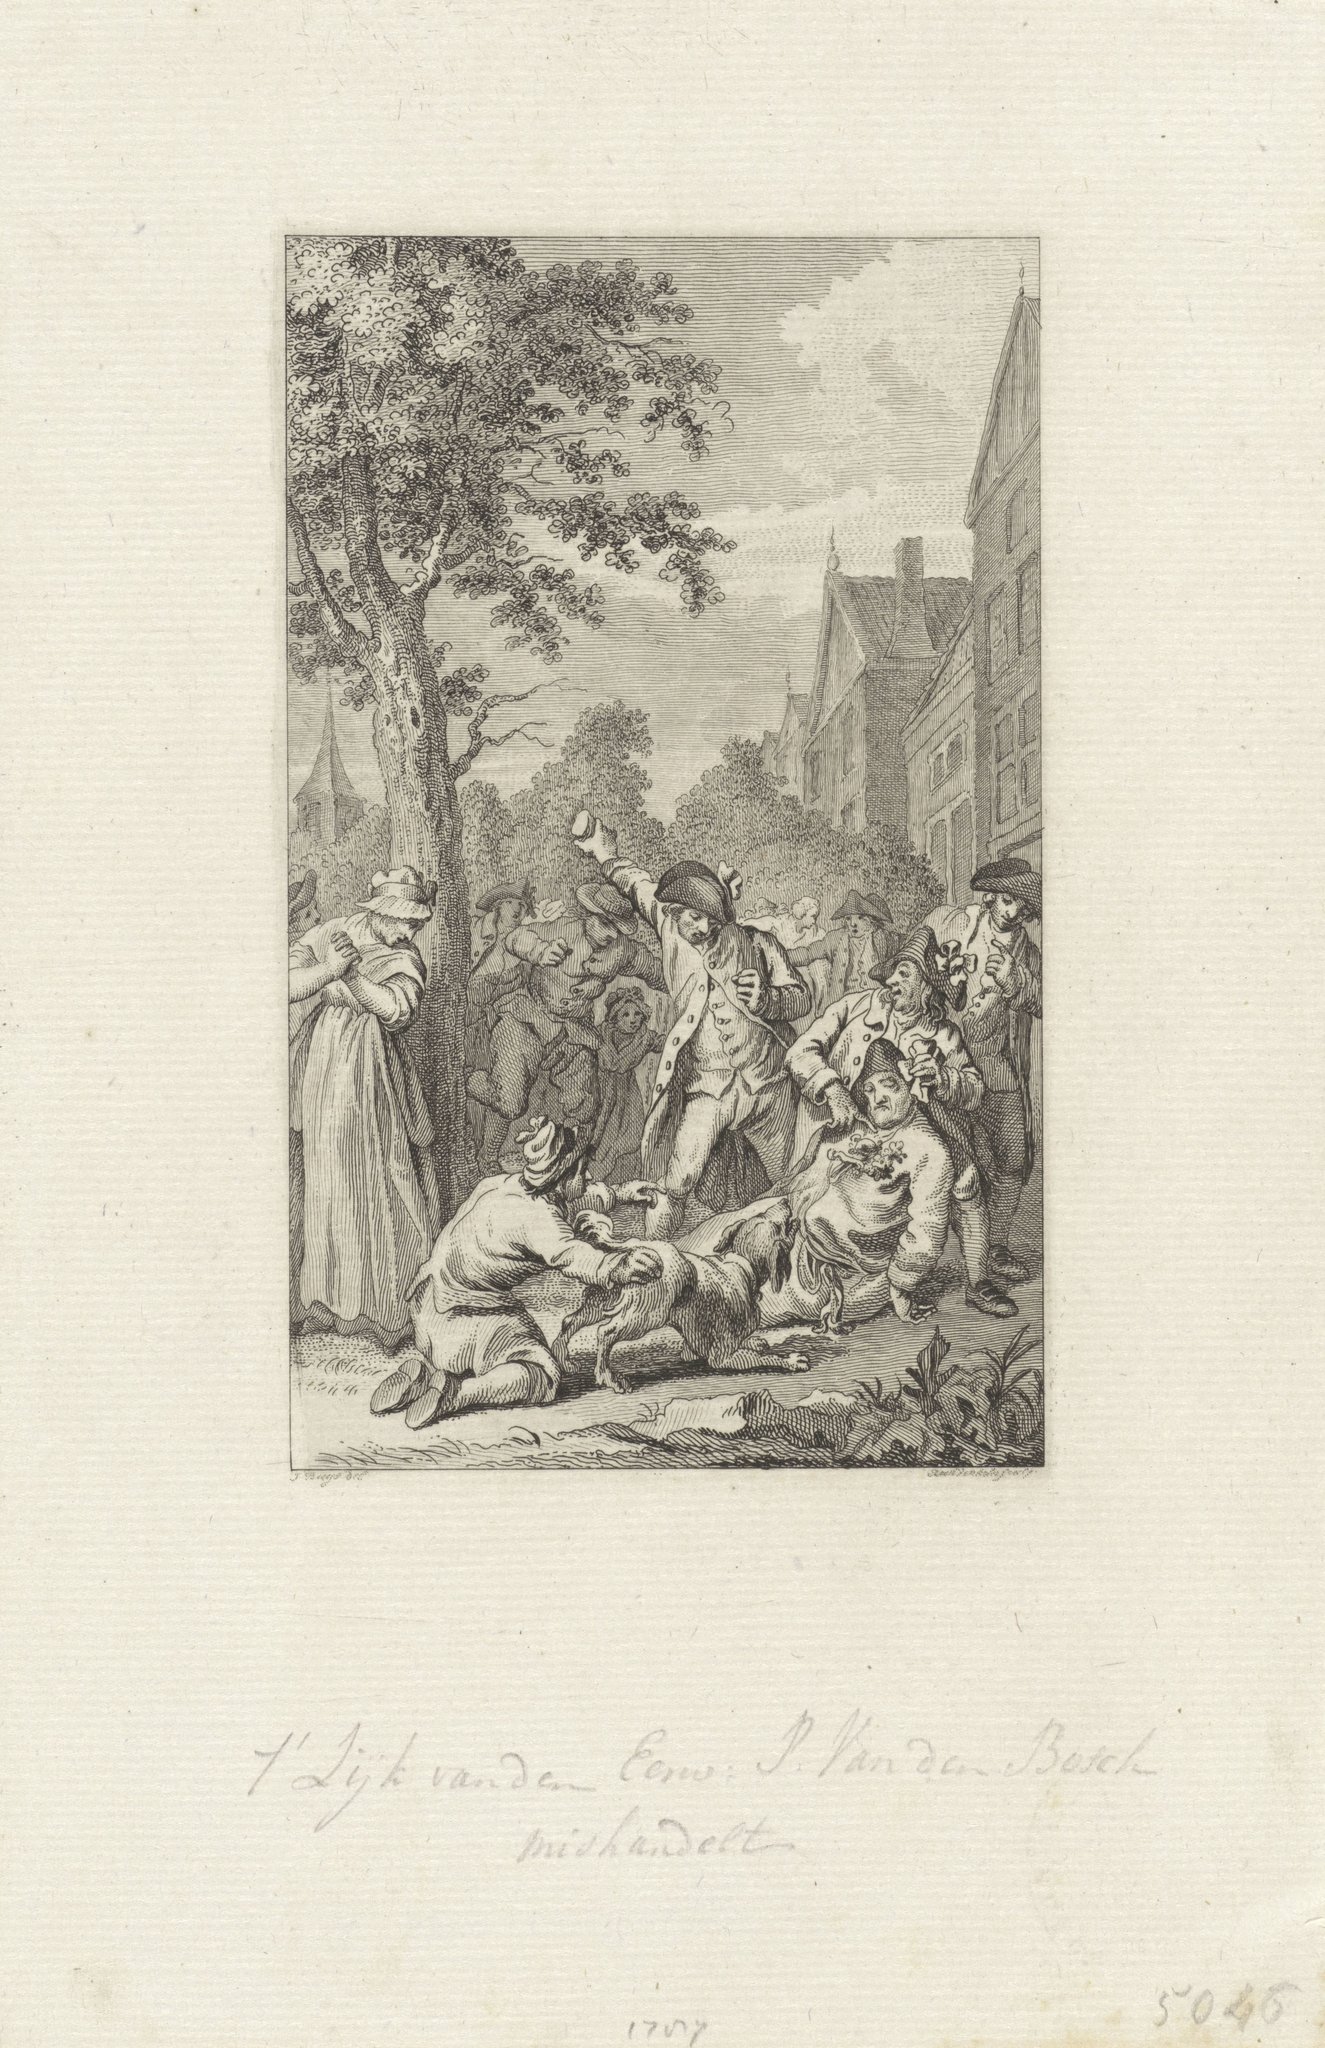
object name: history print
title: Mishandeling van het lijk van predikant P. van den Bosch te Zoetermeer, 1787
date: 1798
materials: paper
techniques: engraving, etching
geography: amsterdam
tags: violation of the corpse, patriots (1780-1795)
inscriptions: collector's mark: Lugt 240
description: Gebruikt als illustratie in: P.A. Loosjes. Vaderlandsche historie, vervattende de geschiedenissen, der Vereenigde Nederlanden (...). Ten onmiddelyken vervolge van Wagenaar's Vaderlandsche historie. Amsterdam: Johannes Allart, dl. 20.